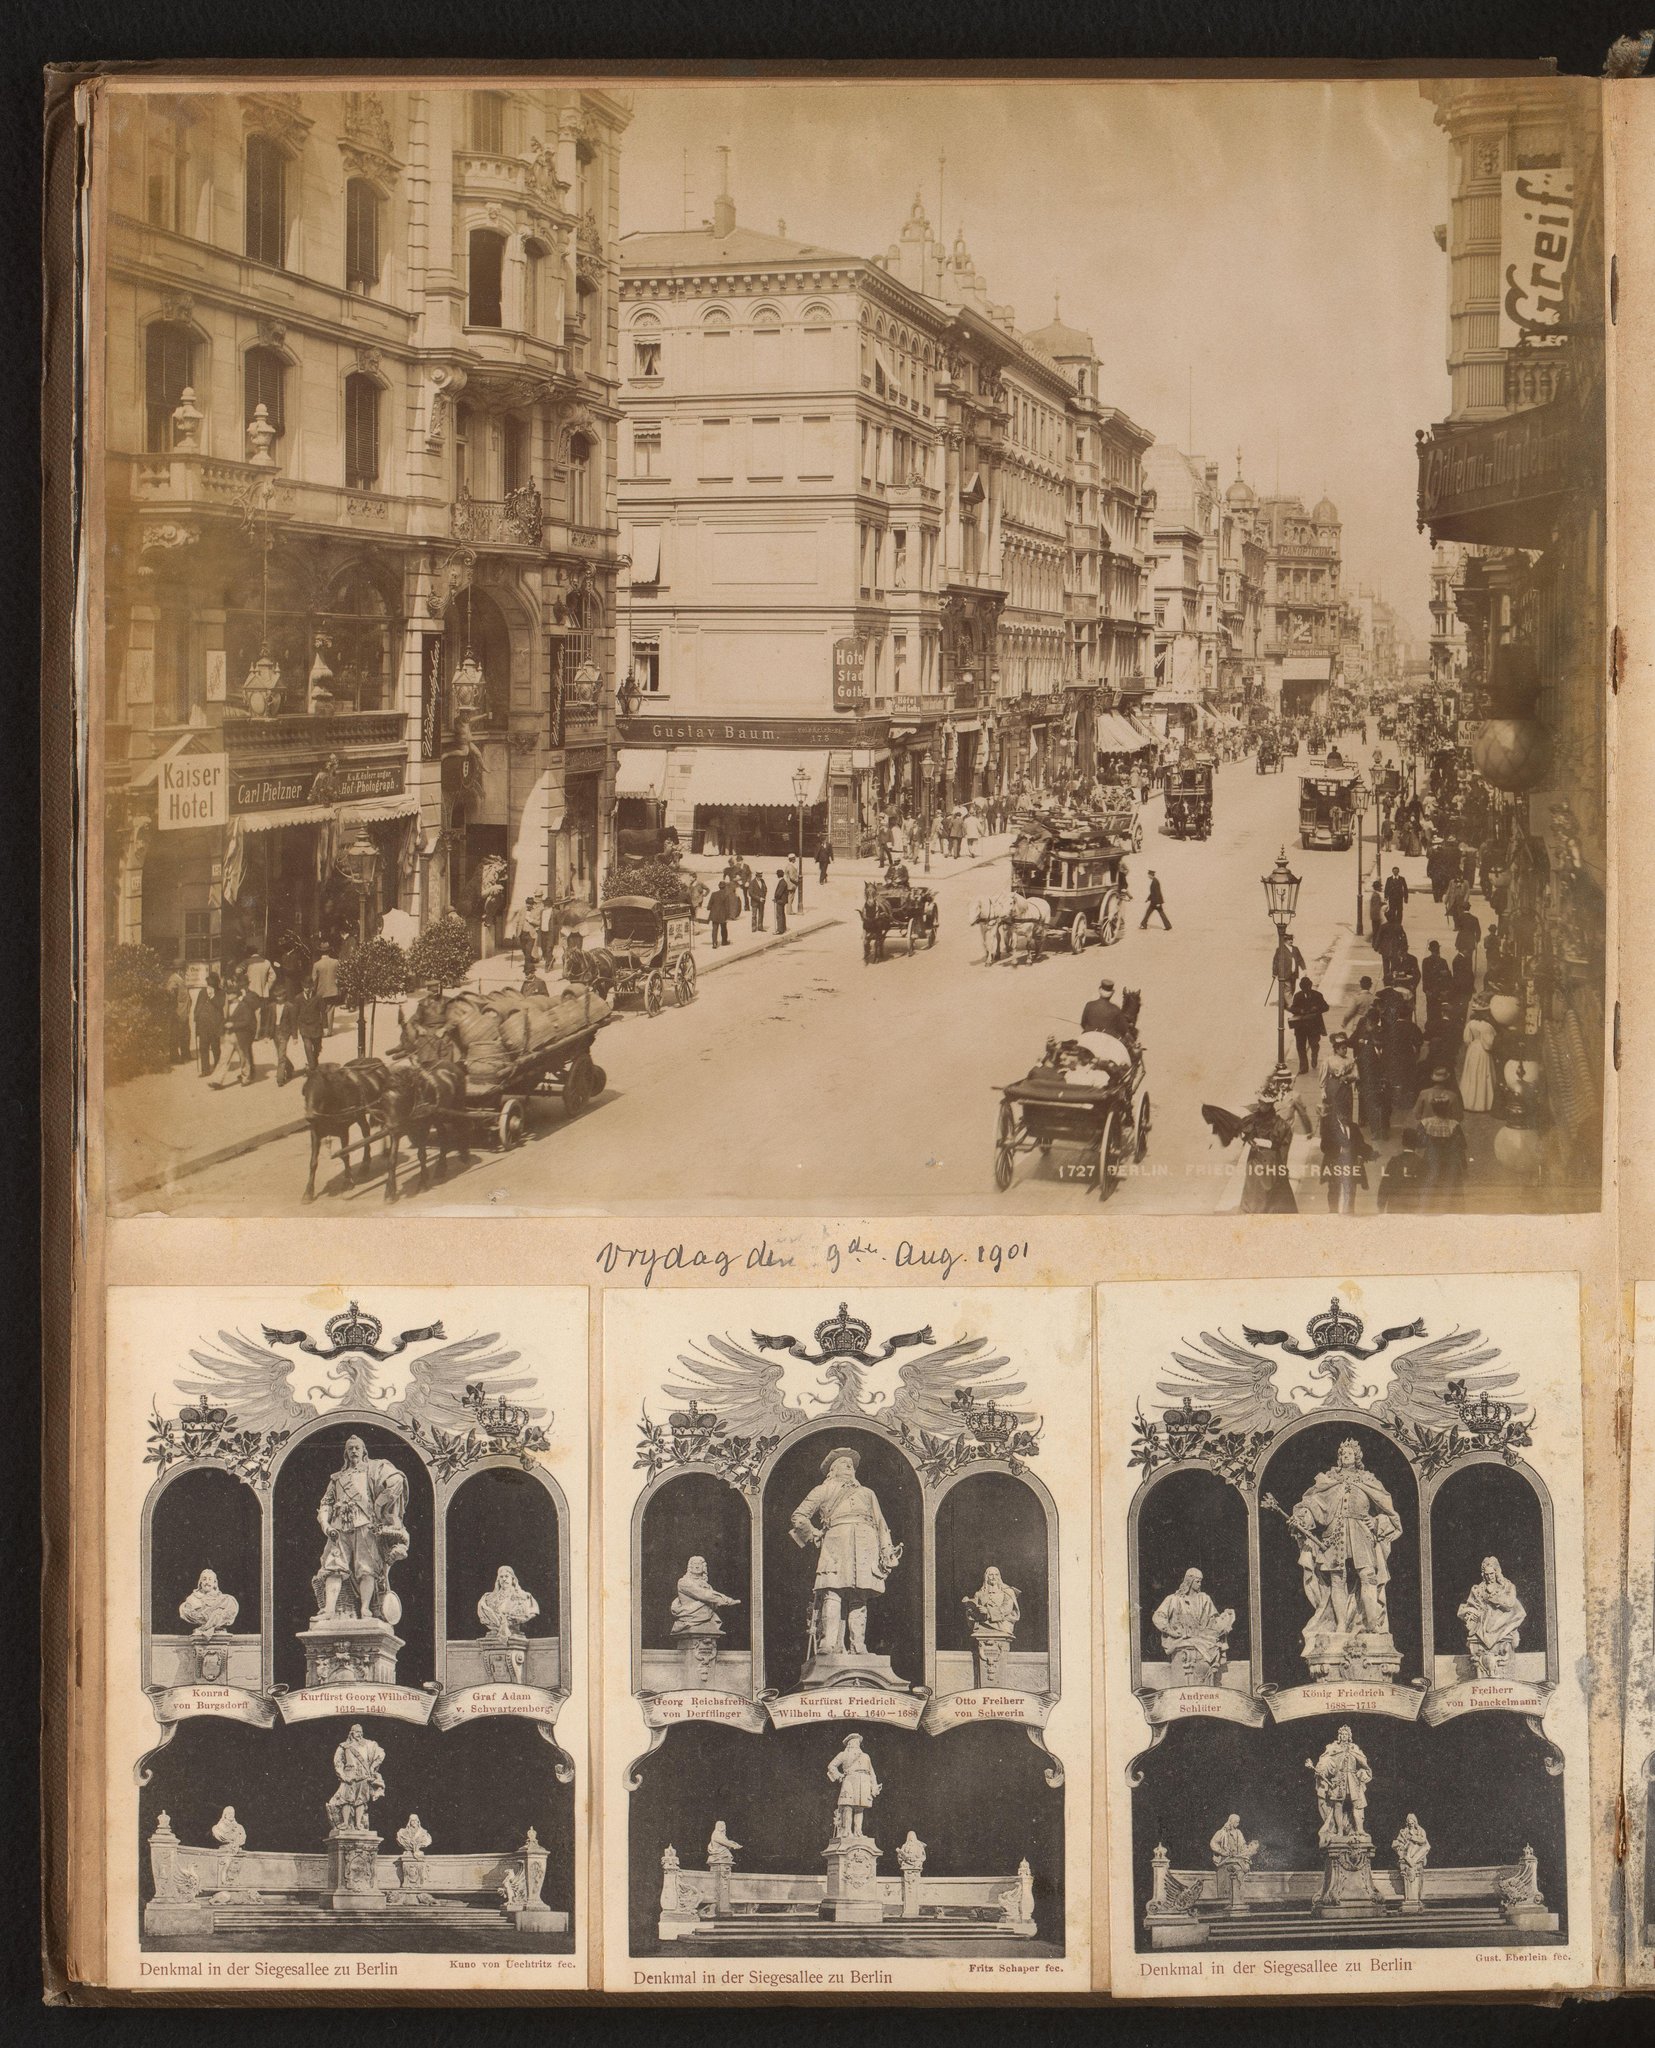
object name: photomechanical print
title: Gezicht op de Friedrichstrasse en beelden langs de Siegesallee, Berlijn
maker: Anonymous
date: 1896-1901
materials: paper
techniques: albumen print, photograph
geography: berlin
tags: piece of sculpture, reproduction of a piece of sculpture, street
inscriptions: title: ‘1727 Berlin. Friedrichstrasse. L.L.’, inscription: ‘Vrijdag den 9de Aug. 1901’, inscription: ‘Denkmal in der Siegesallee zu Berlin (...)’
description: Deze foto en fotomechanische afdrukken maken deel uit van een album.